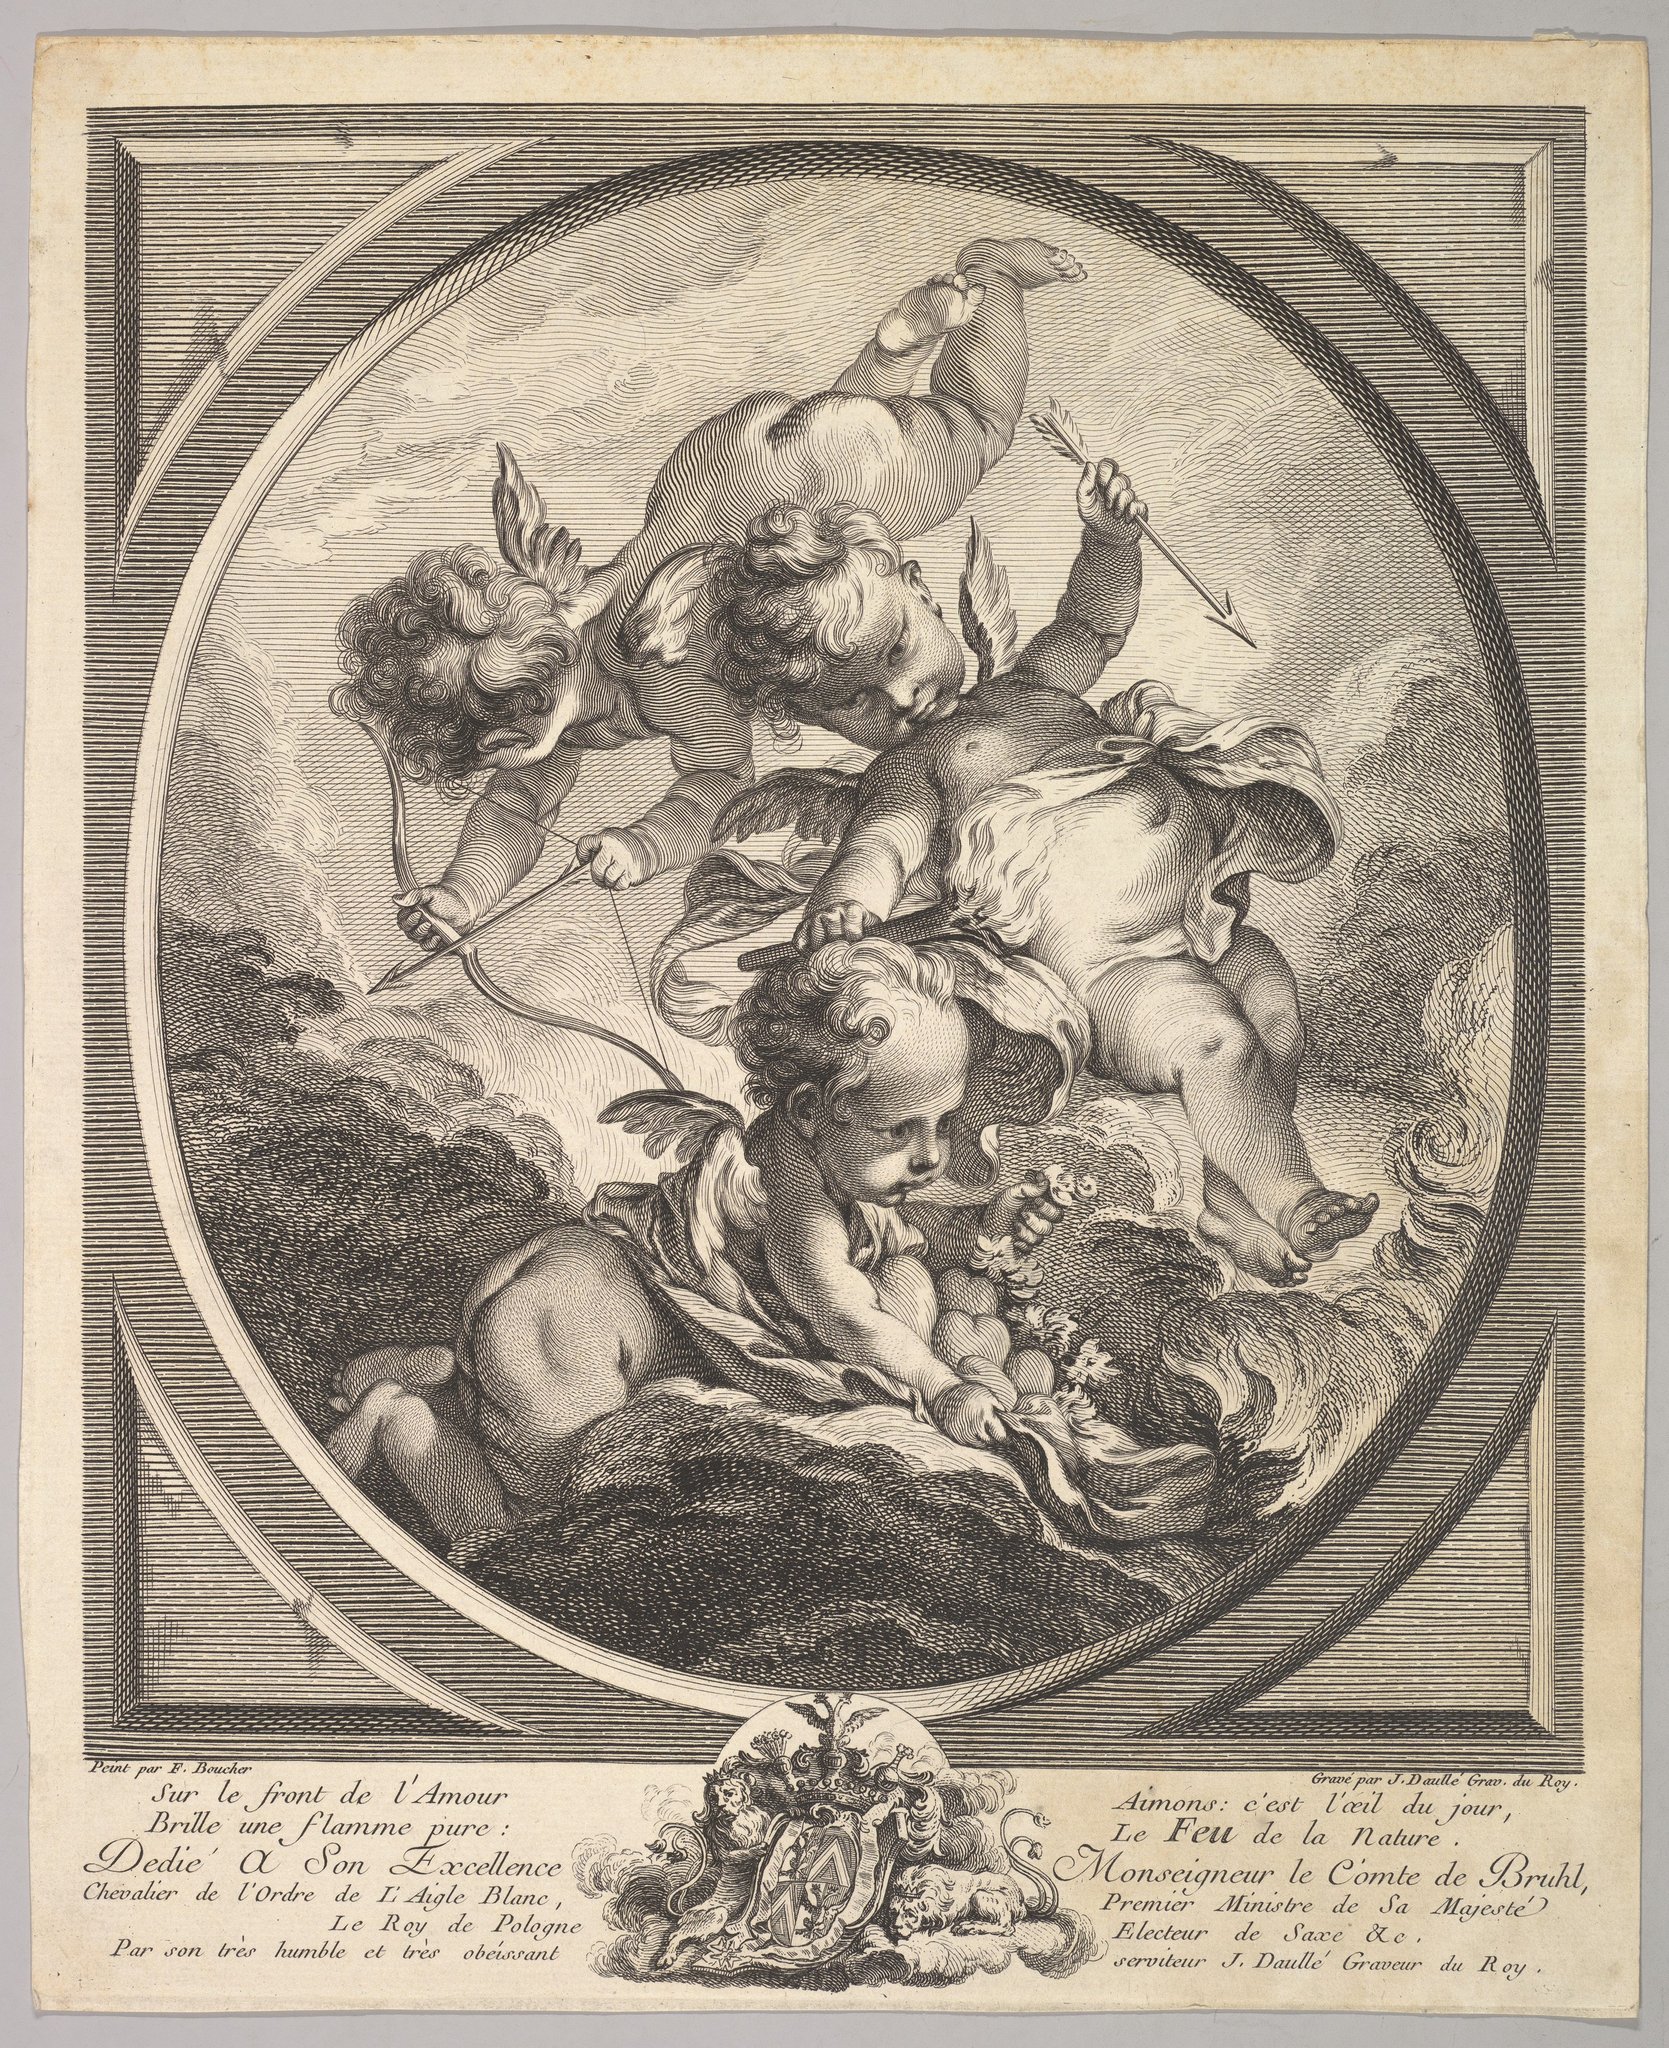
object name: print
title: Fire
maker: jean daullé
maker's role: artist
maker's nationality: french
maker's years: 1703-1763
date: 1748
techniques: engraving, etching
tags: cupid